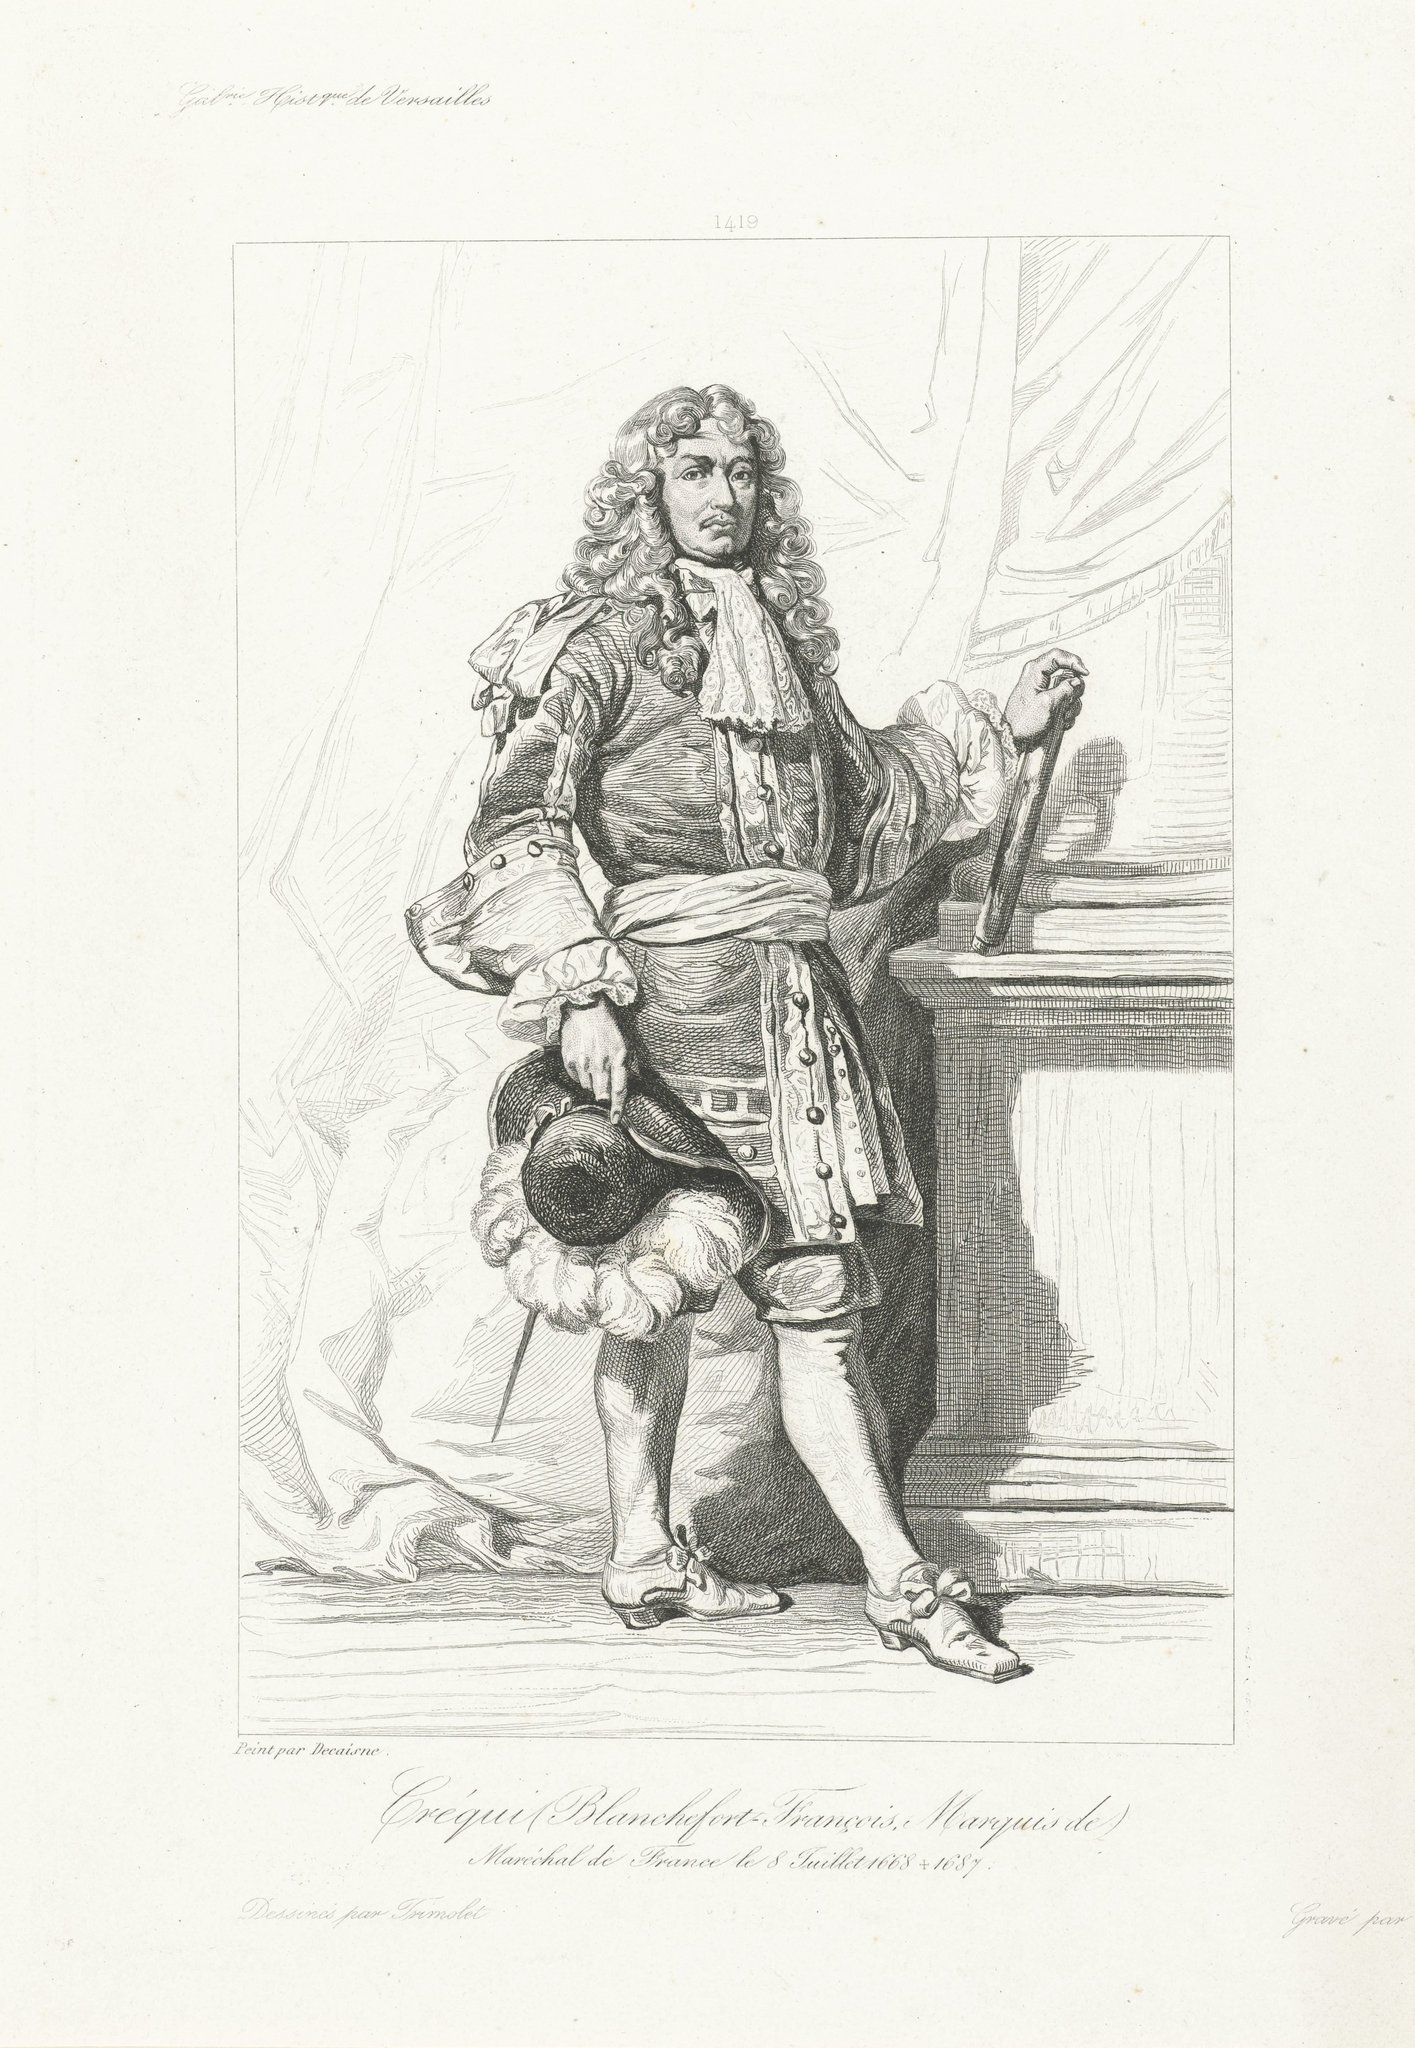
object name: book illustration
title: Portret van François de Créquy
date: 1837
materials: paper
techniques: engraving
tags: paris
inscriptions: collector's mark: Lugt 2228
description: Prent gebruikt in: Janin, M. Jules. Galleries historique de Versailles. Parijs: s.n. 1837.